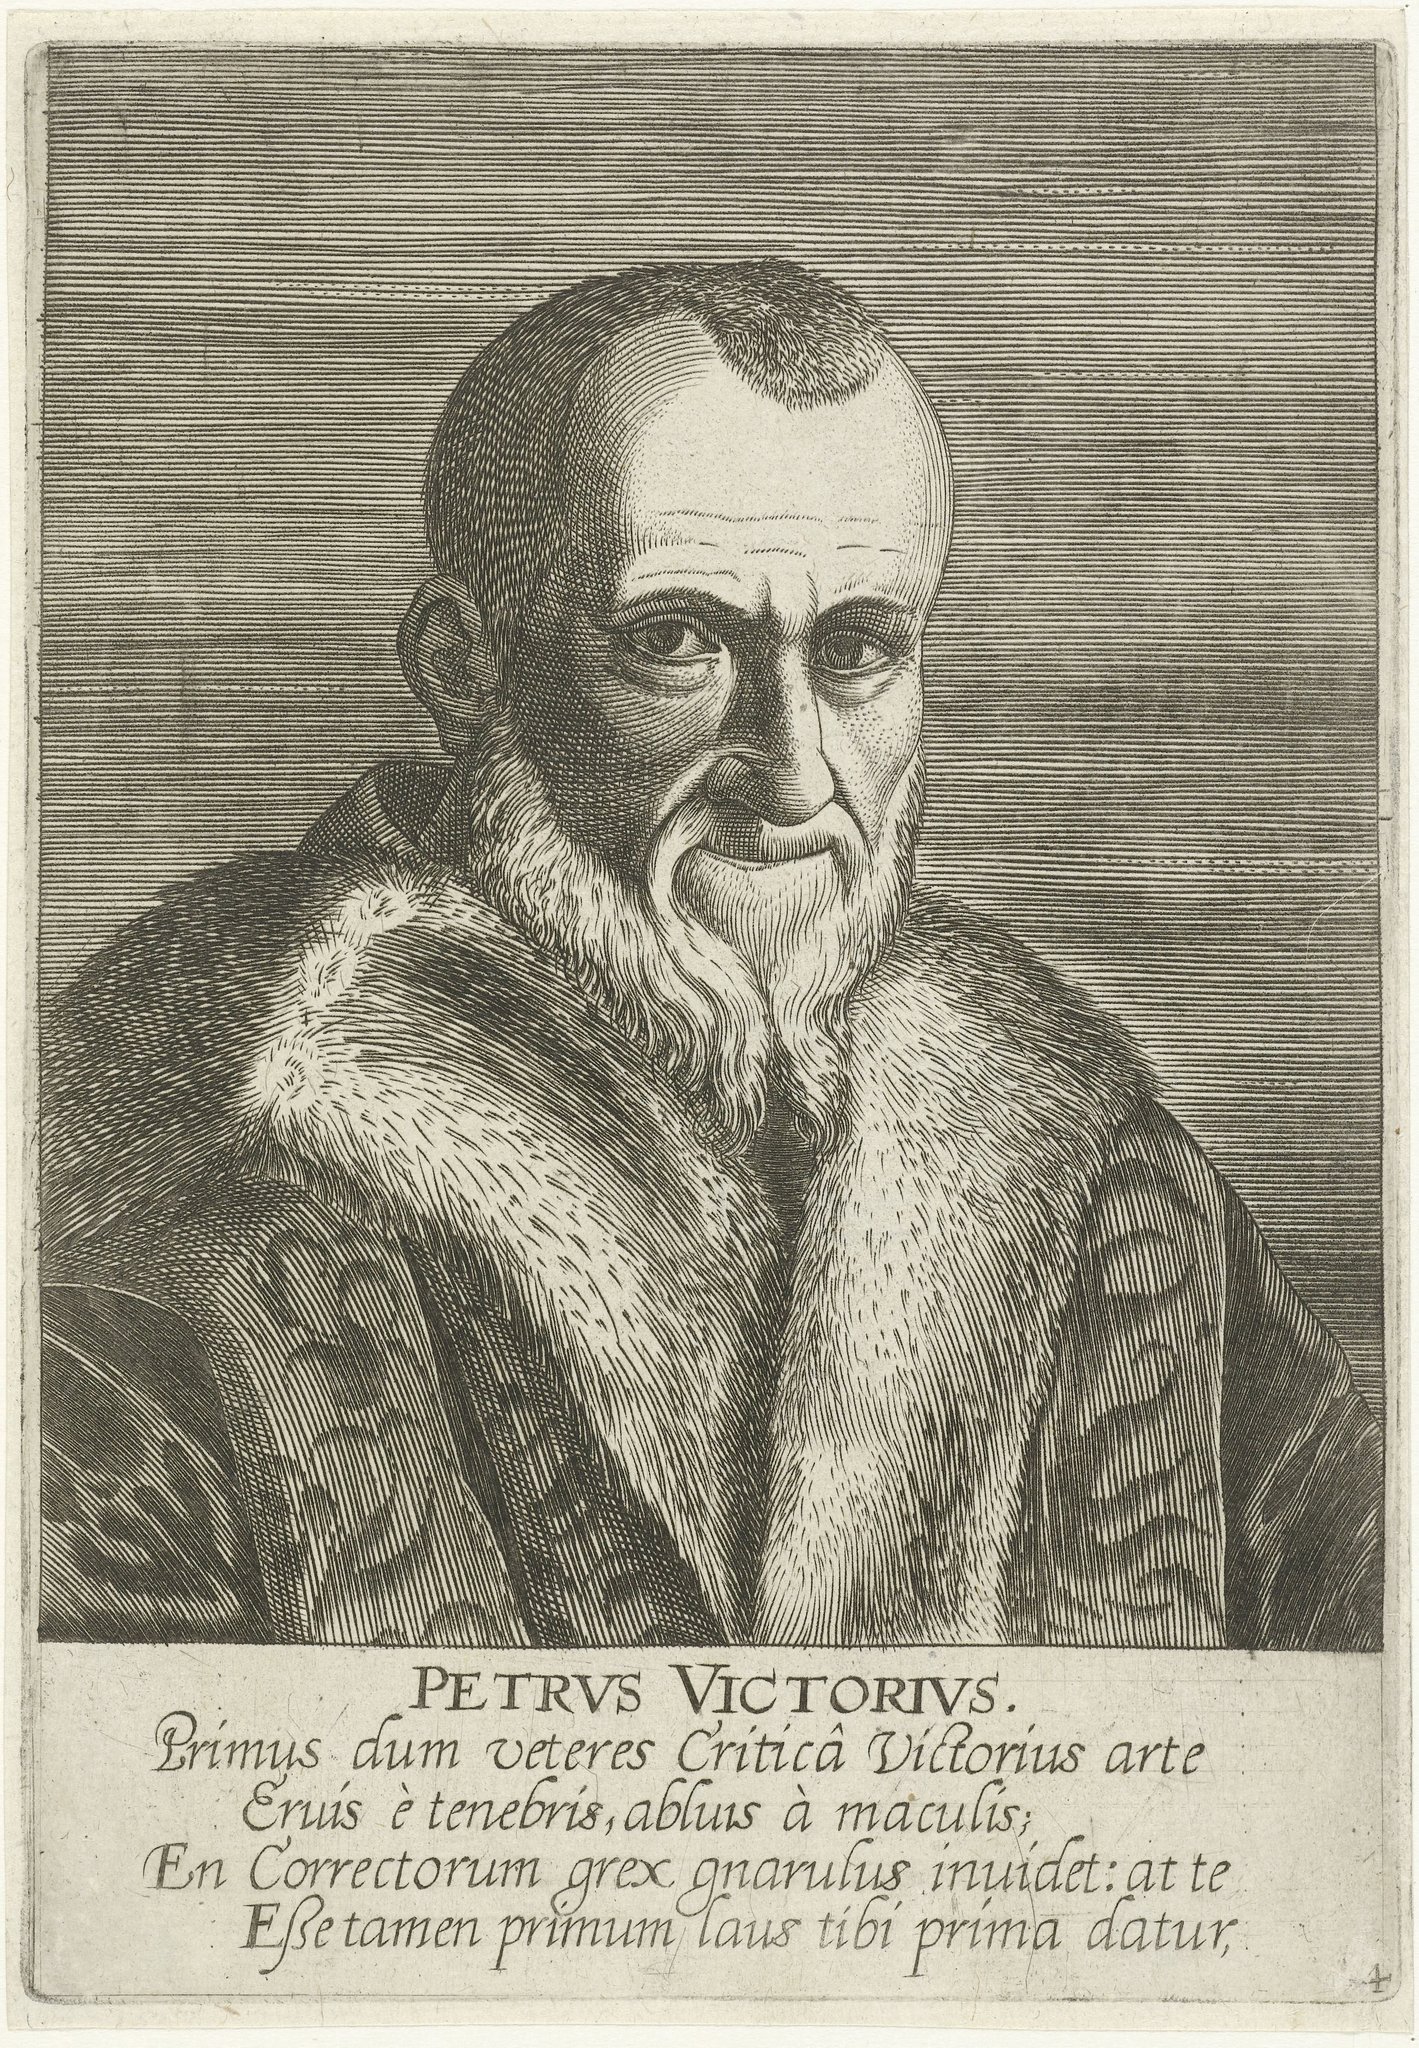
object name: print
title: Petrvs Victorivs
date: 1587-1606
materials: paper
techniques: engraving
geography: antwerp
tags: schrijver, filoloog, piero vettòri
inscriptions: collector's mark: Lugt 2228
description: Portret van Pietro Vettori, een Italiaanse geleerde aan het hof van de Medici. Buste naar rechts. De prent heeft een Latijns onderschrift en maakt deel uit van een serie van beroemde geleerden.